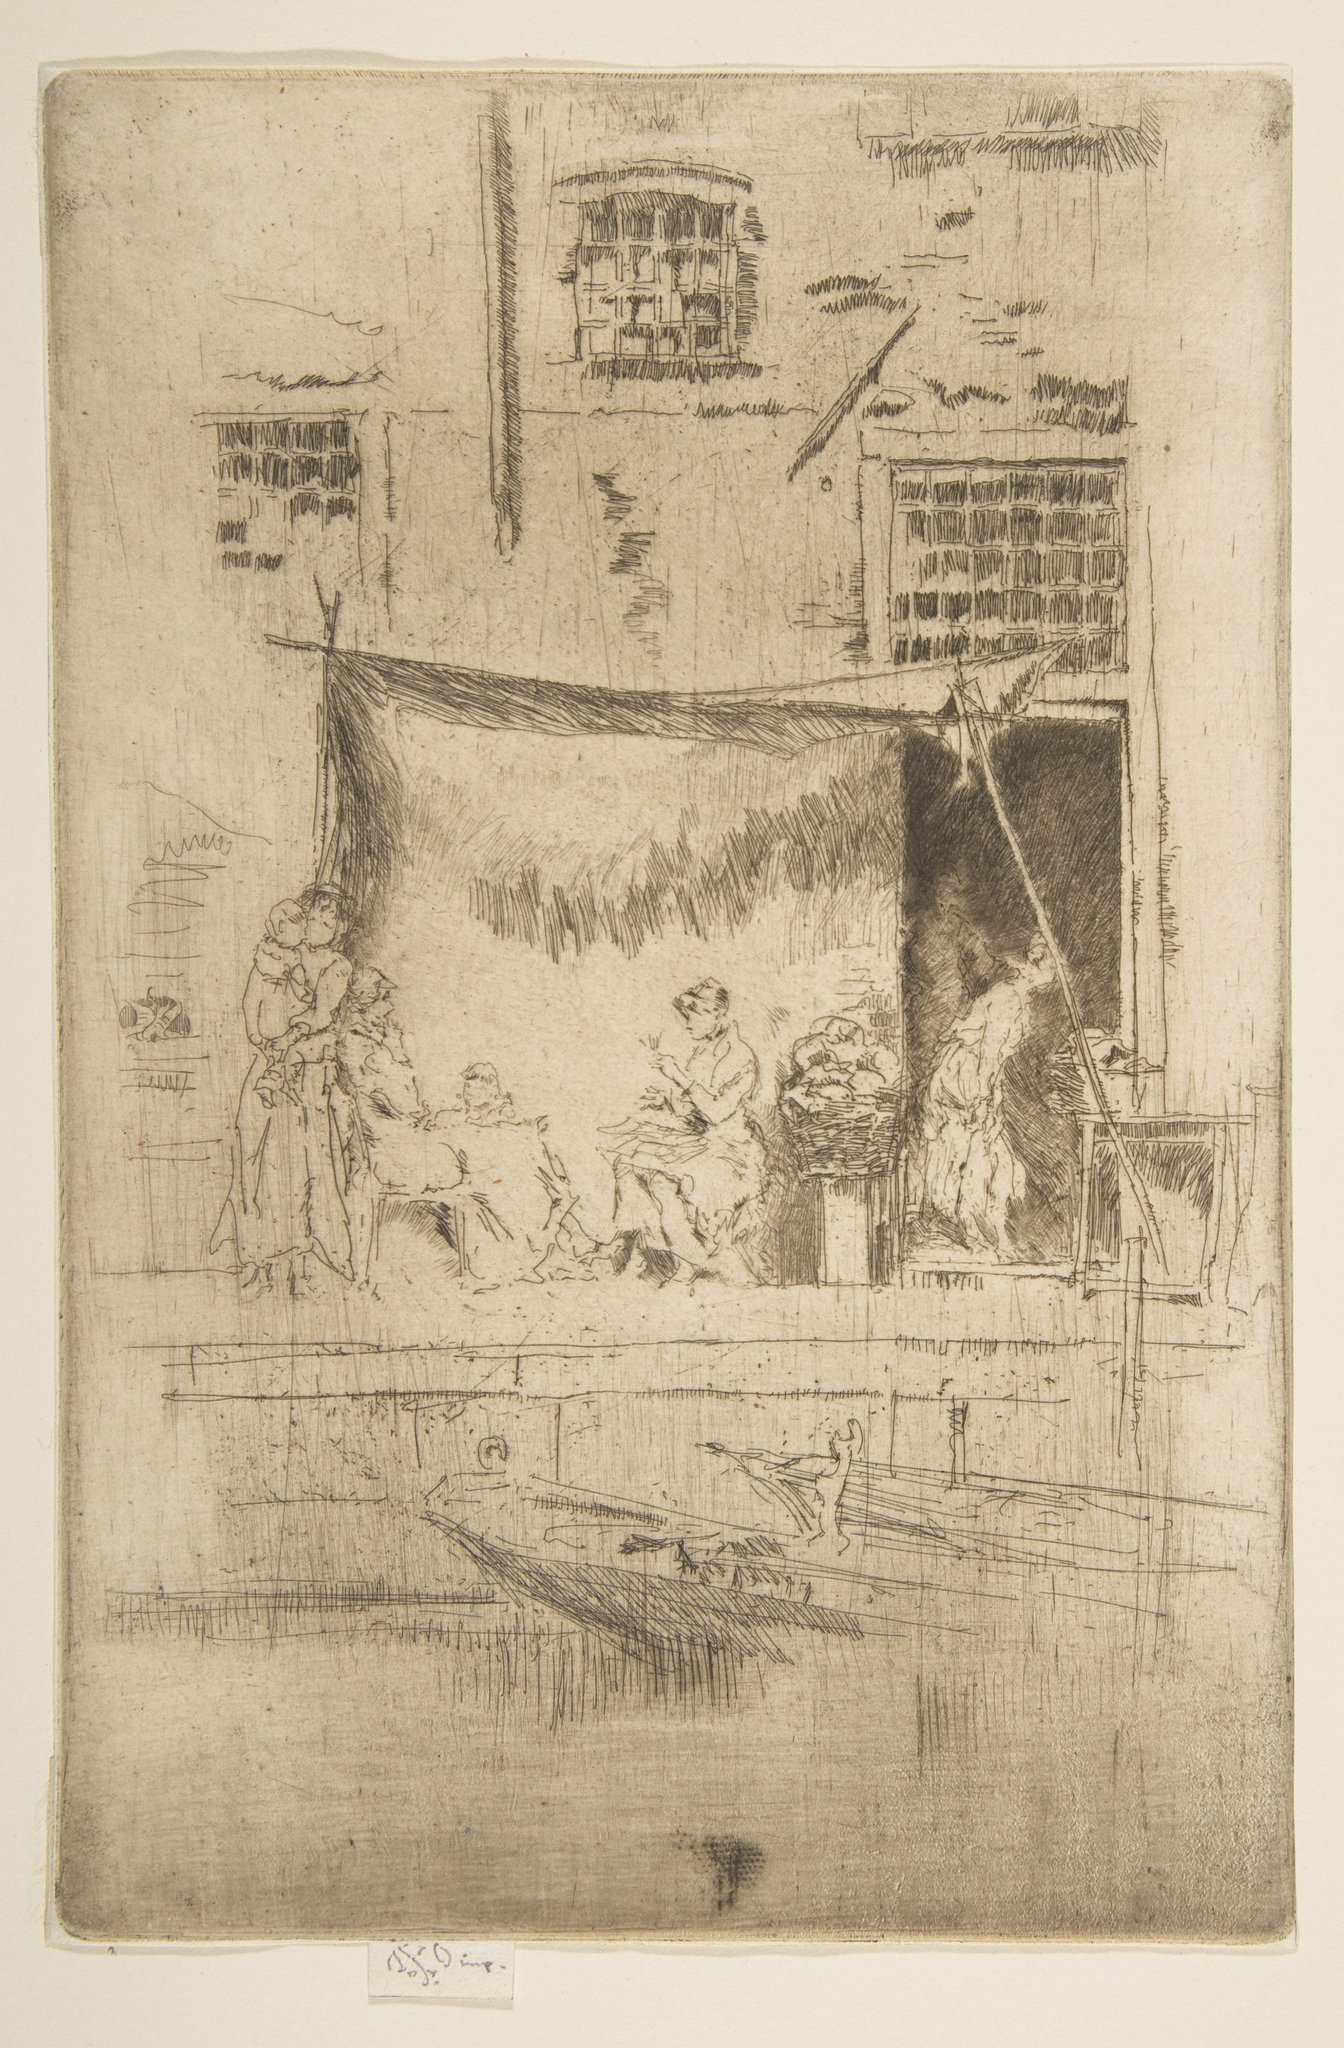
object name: print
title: Fruit Stall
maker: james mcneill whistler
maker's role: artist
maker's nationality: american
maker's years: 1834-1903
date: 1879-1880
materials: ink, paper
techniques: drypoint, etching, printing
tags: infants,women,boats